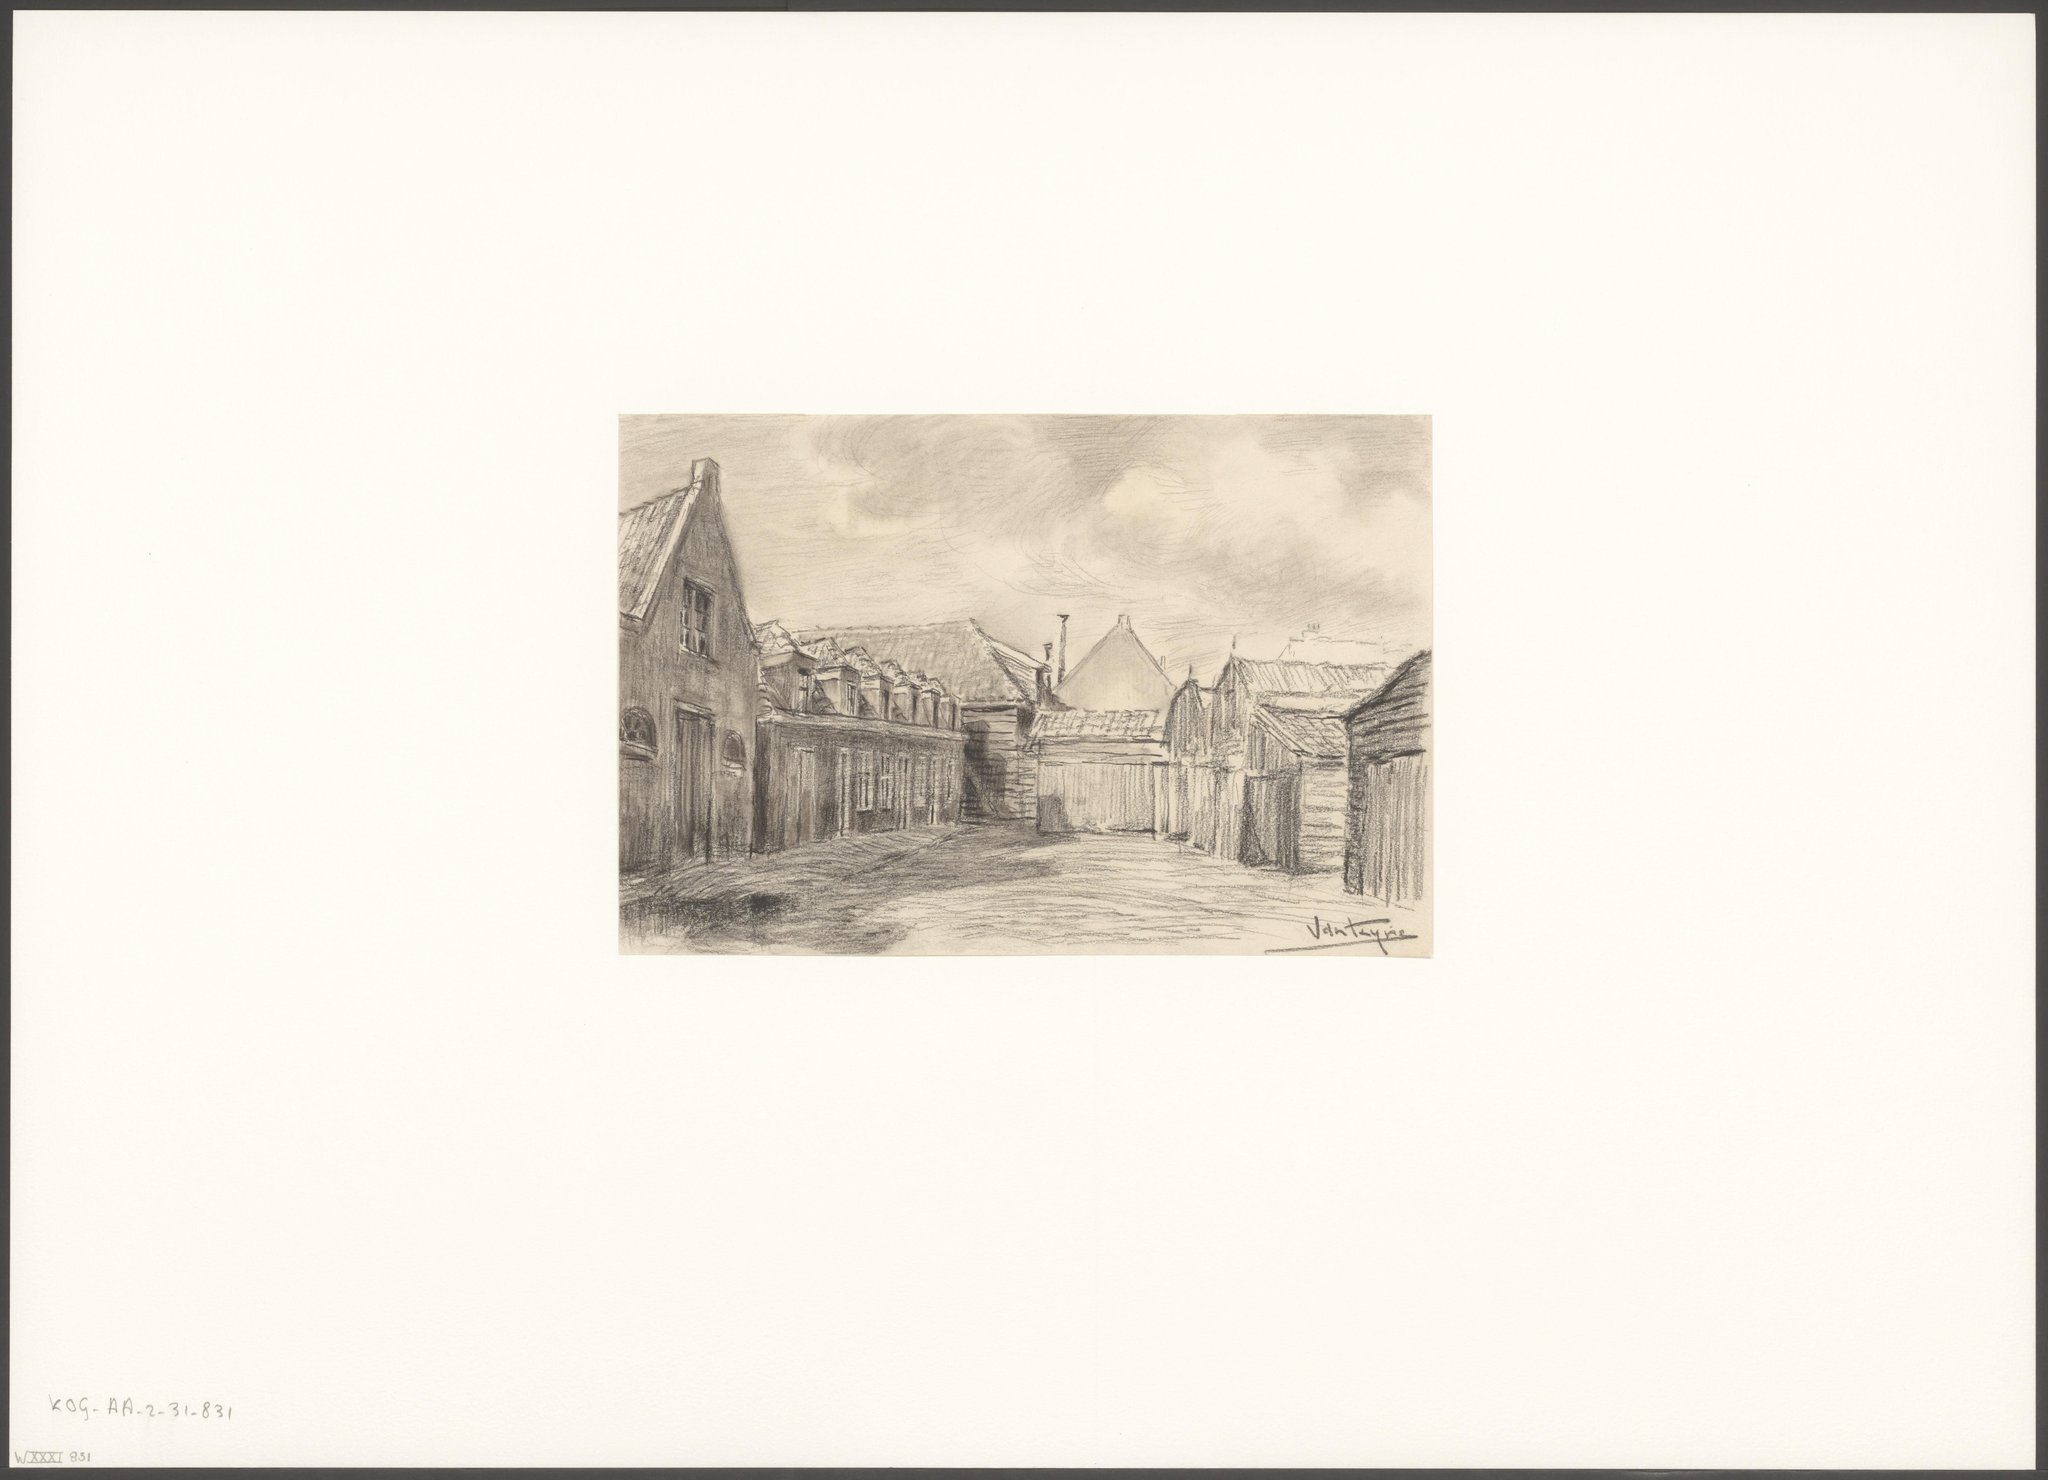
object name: drawing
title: Gezicht op enkele panden achter de Sloterkade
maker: anthonie van teijn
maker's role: draughtsman, painter, print maker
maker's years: 1863-1943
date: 1910-1927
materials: chalk, paper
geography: amsterdam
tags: city-view in general; 'veduta', the usual house or row of houses, street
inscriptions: signature: ‘VanTeyne’, inscription: ‘Bebouwd achter terrein (...) oct 1927. / vanEck’, collector's mark: Lugt 800a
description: Tekening binnen de Atlas Van Eck ingedeeld op wijknummer 31.